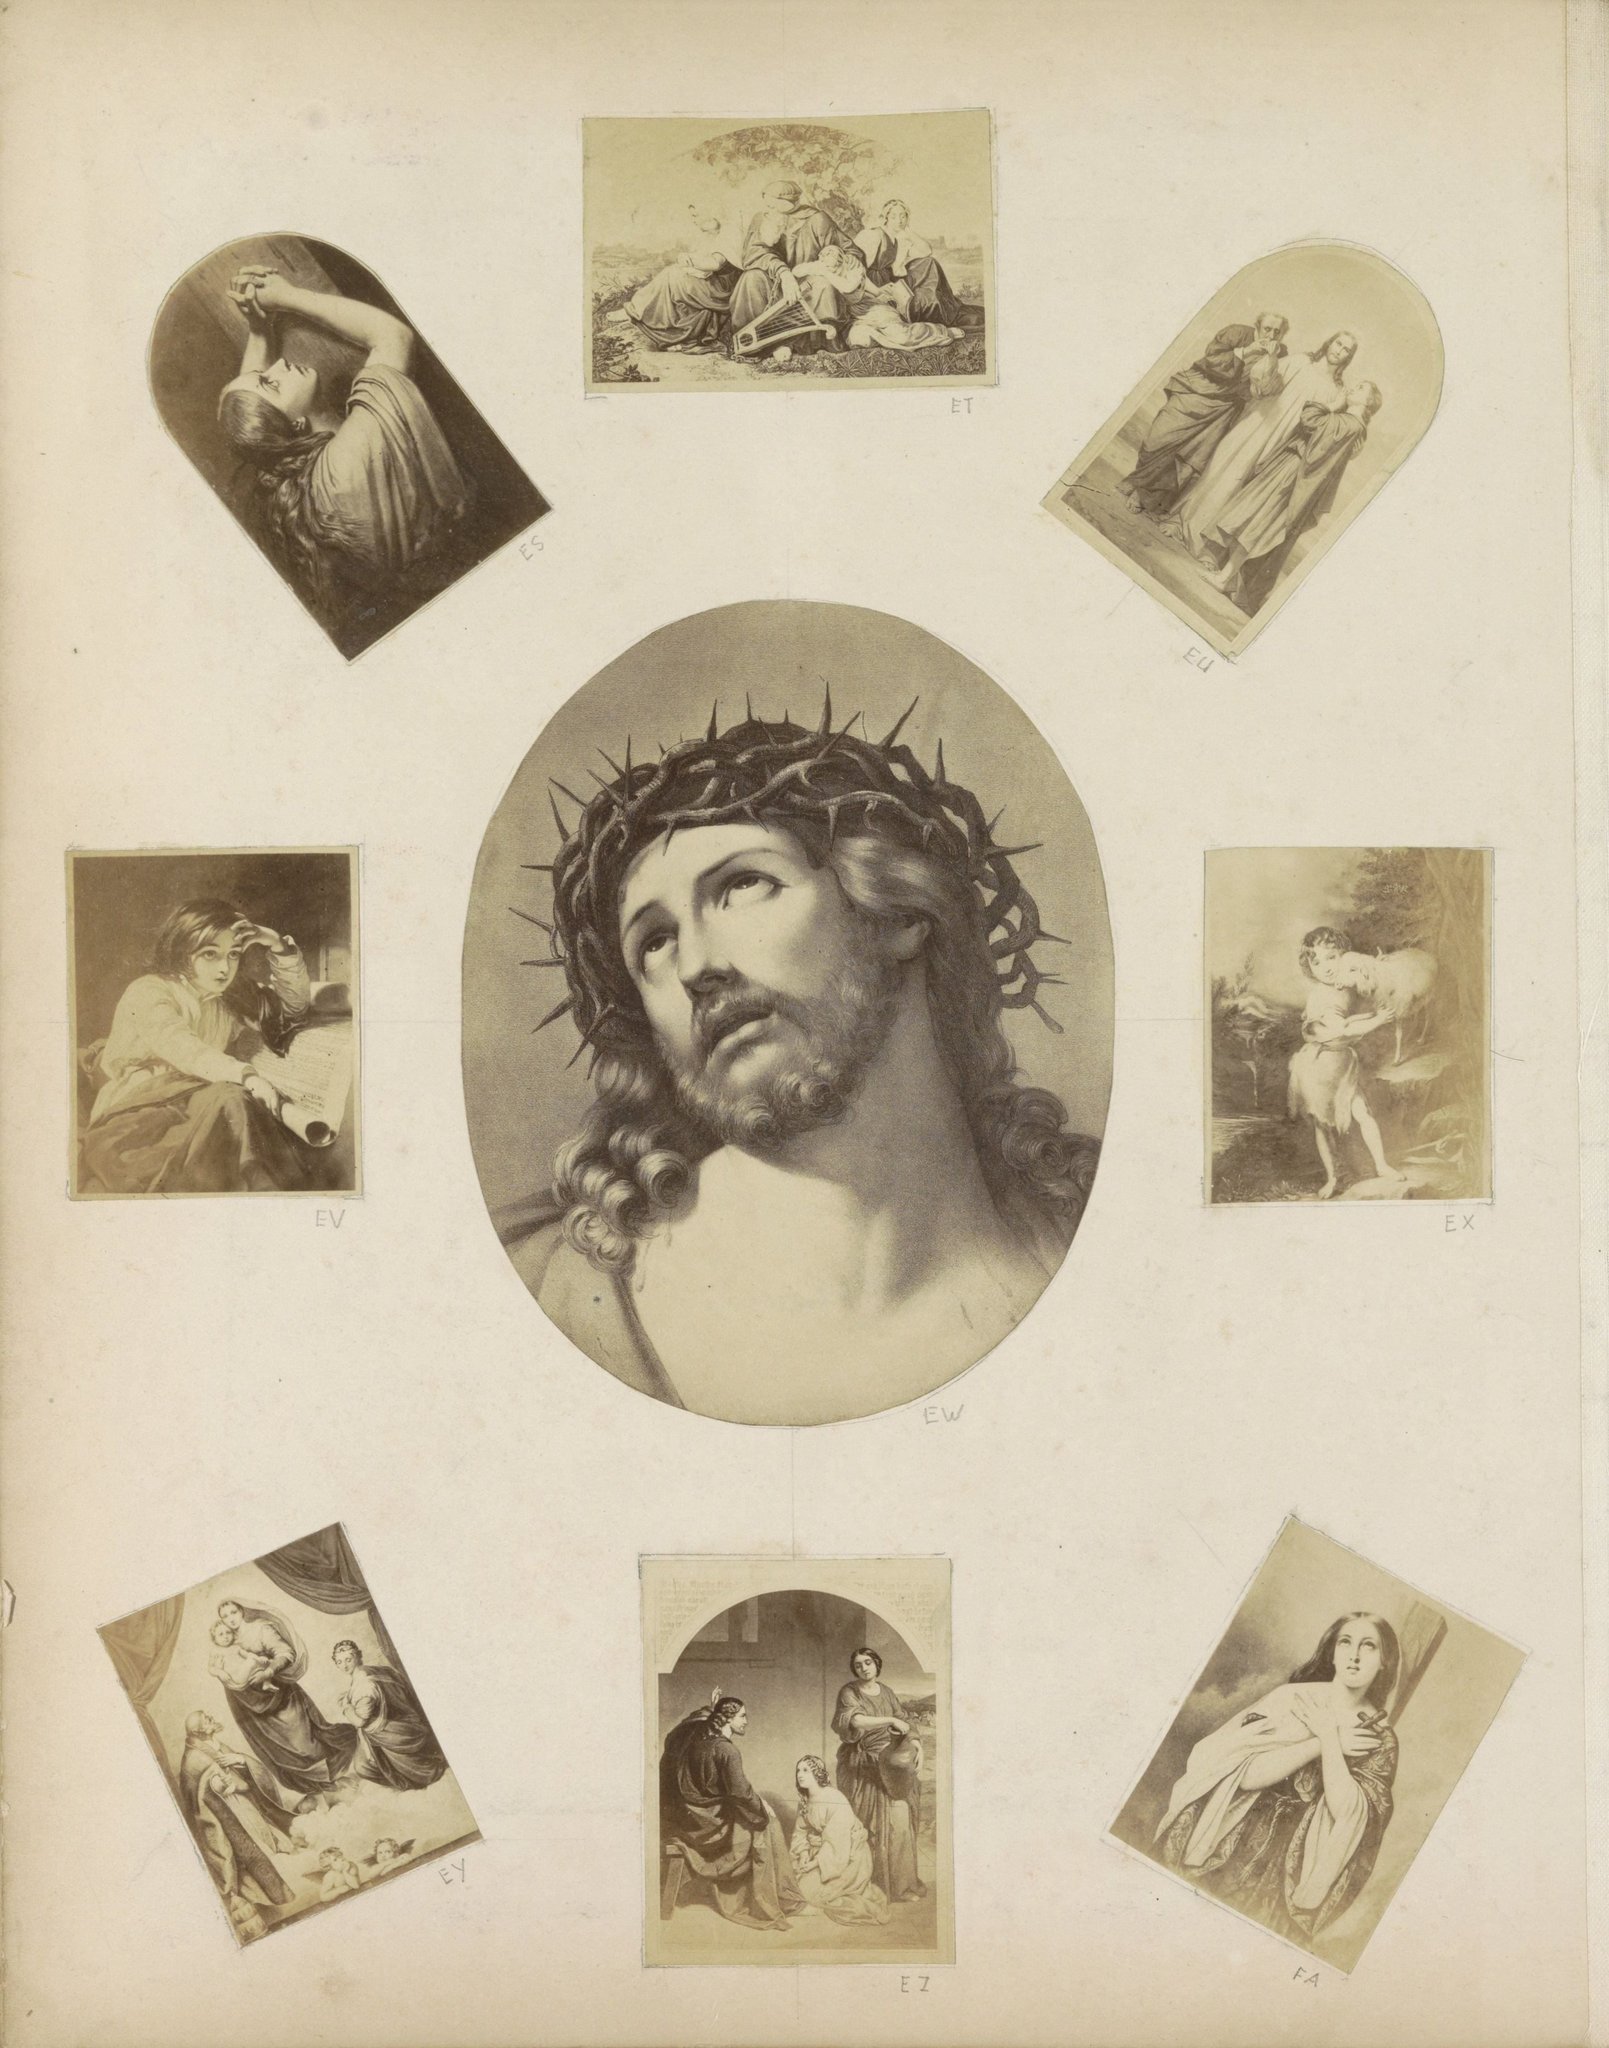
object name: photograph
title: Fotoreproductie van (vermoedelijk) een prent naar een schilderij van Rafaël (Sixtijnse Madonna)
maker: Anonymous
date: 1850-1870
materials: paper, photographic support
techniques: albumen print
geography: england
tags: specific types of madonna with others (+ angels floating in the air), angels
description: Onderdeel van Album met foto's van bezienswaardigheden en landschappen in Engeland en van kunst.